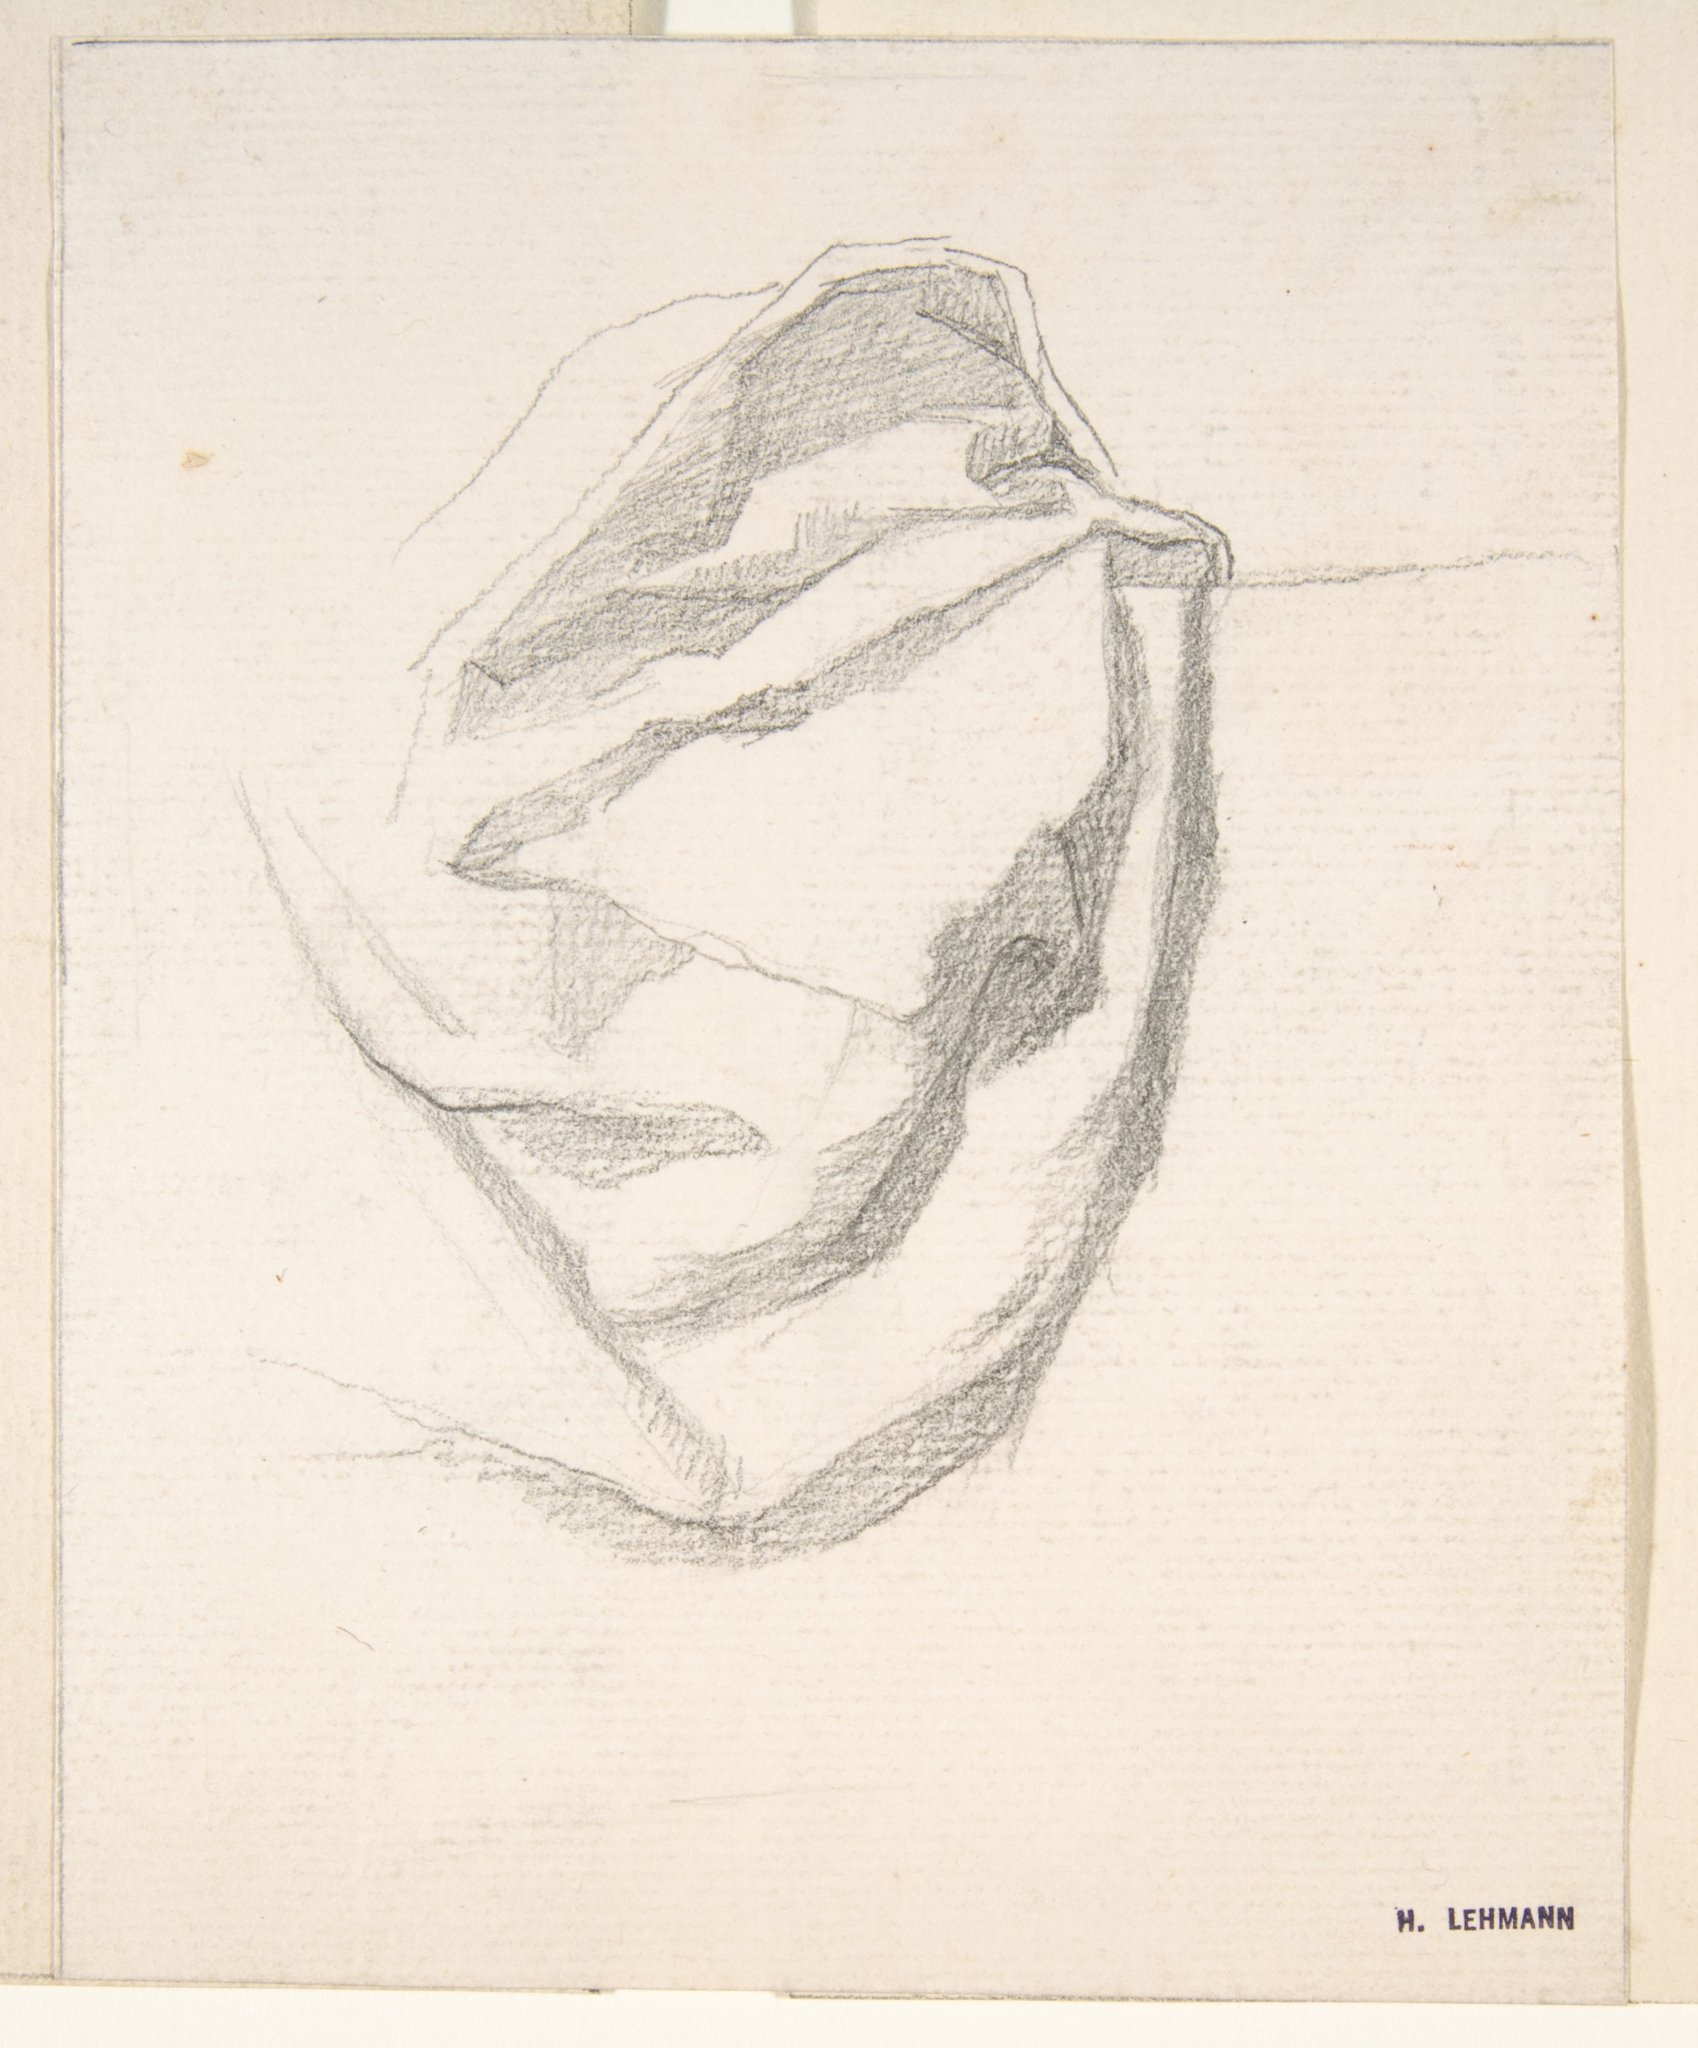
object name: drawing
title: Study of Drapery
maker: henri lehmann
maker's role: artist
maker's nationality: french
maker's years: 1814-1882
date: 1801-1900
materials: graphite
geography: france